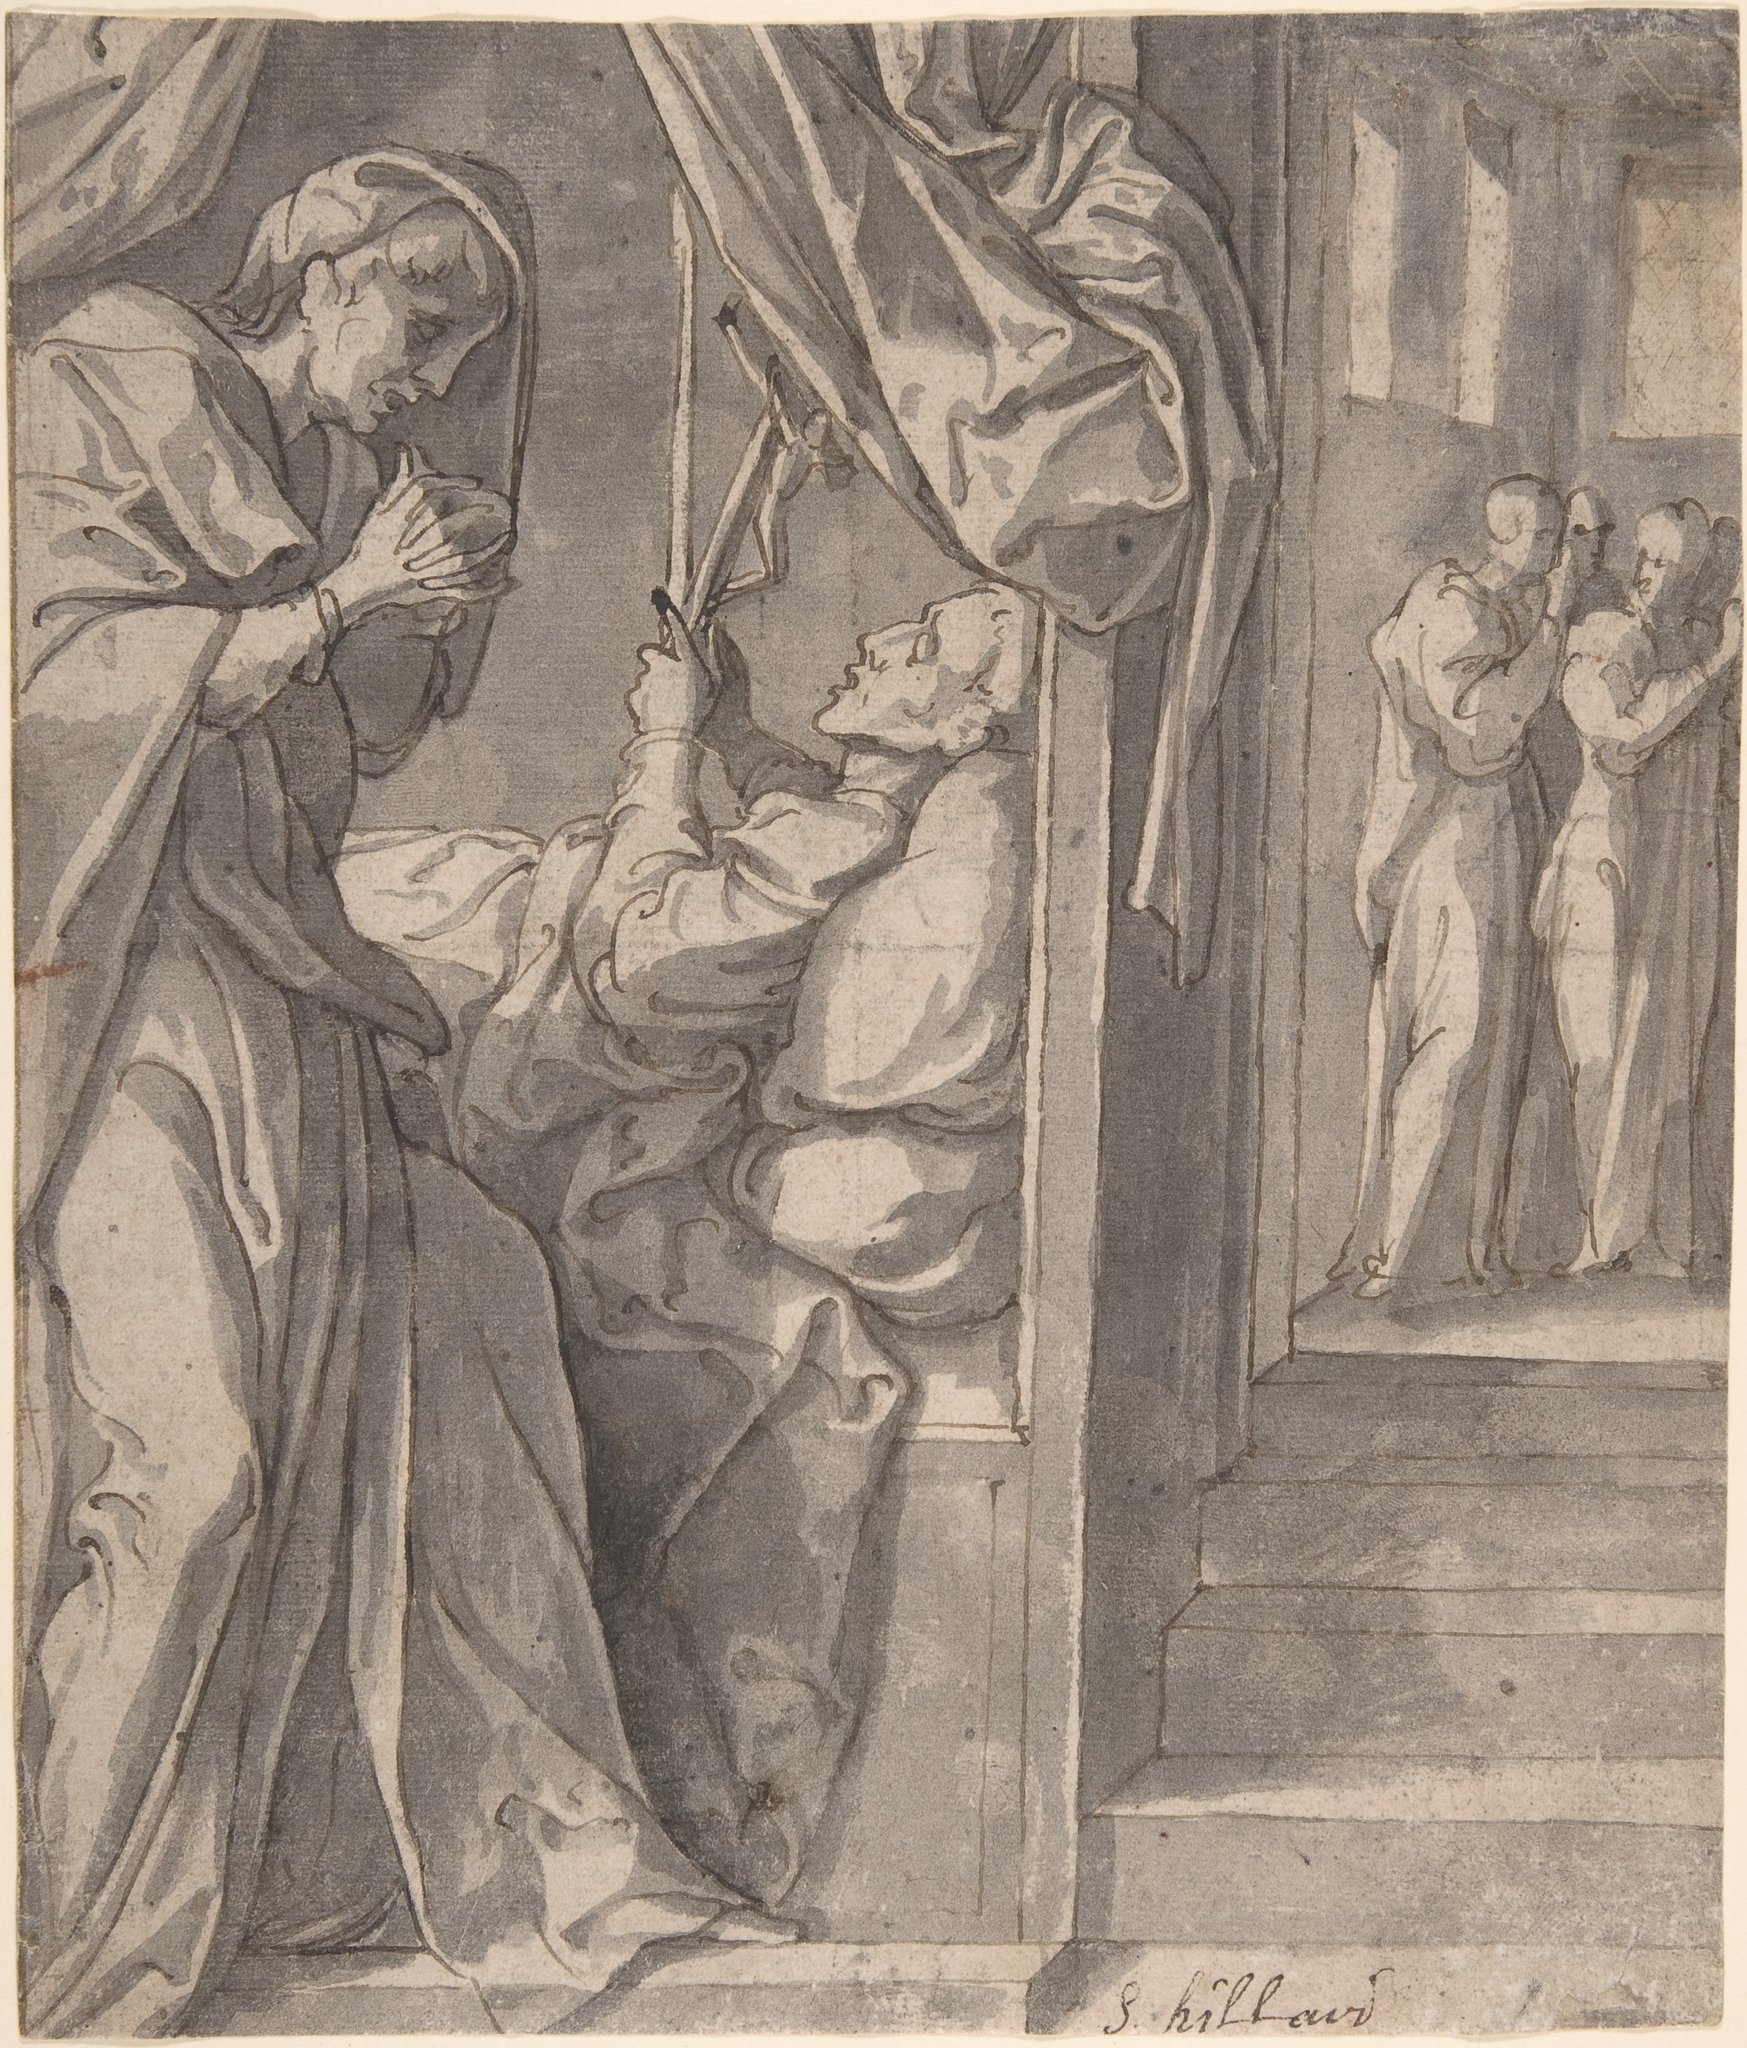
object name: drawing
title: The Death of Saint Hilary (recto); Sketch of an Arm (verso)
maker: jan van scorel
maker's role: artist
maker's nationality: netherlandish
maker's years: 1495-1562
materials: chalk, ink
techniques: pen, wash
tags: human figures,saints